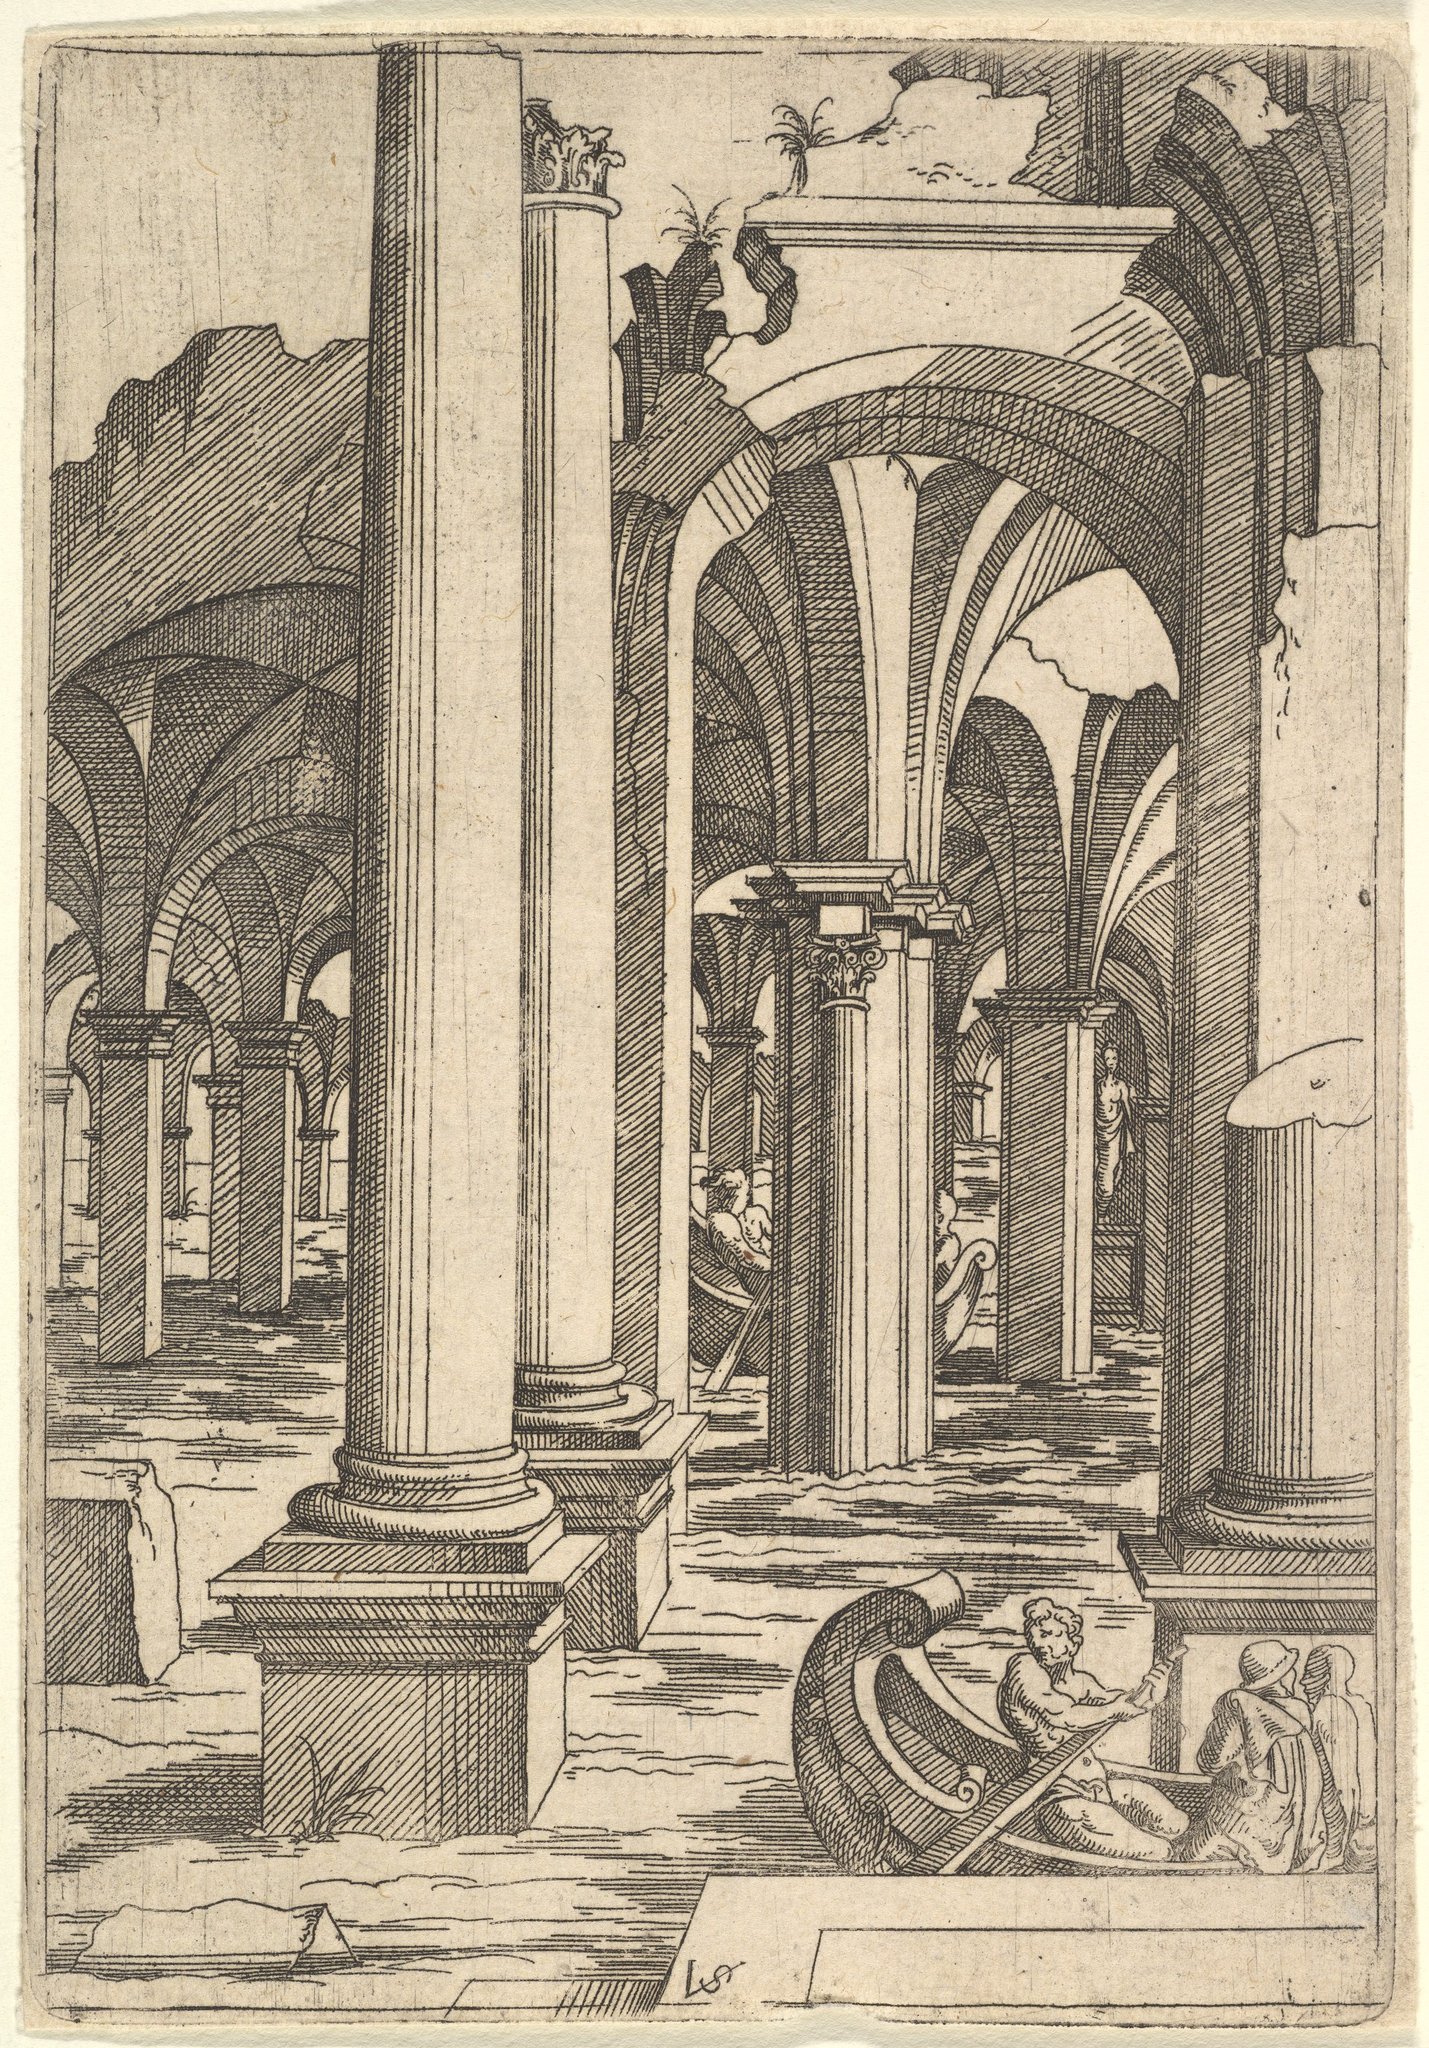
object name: print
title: Boats Rowed Through Inundated Ruins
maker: virgil solis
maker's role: artist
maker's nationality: german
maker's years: 1514-1562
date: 1550-1562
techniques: etching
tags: human figures,arches,columns,ruins,boats